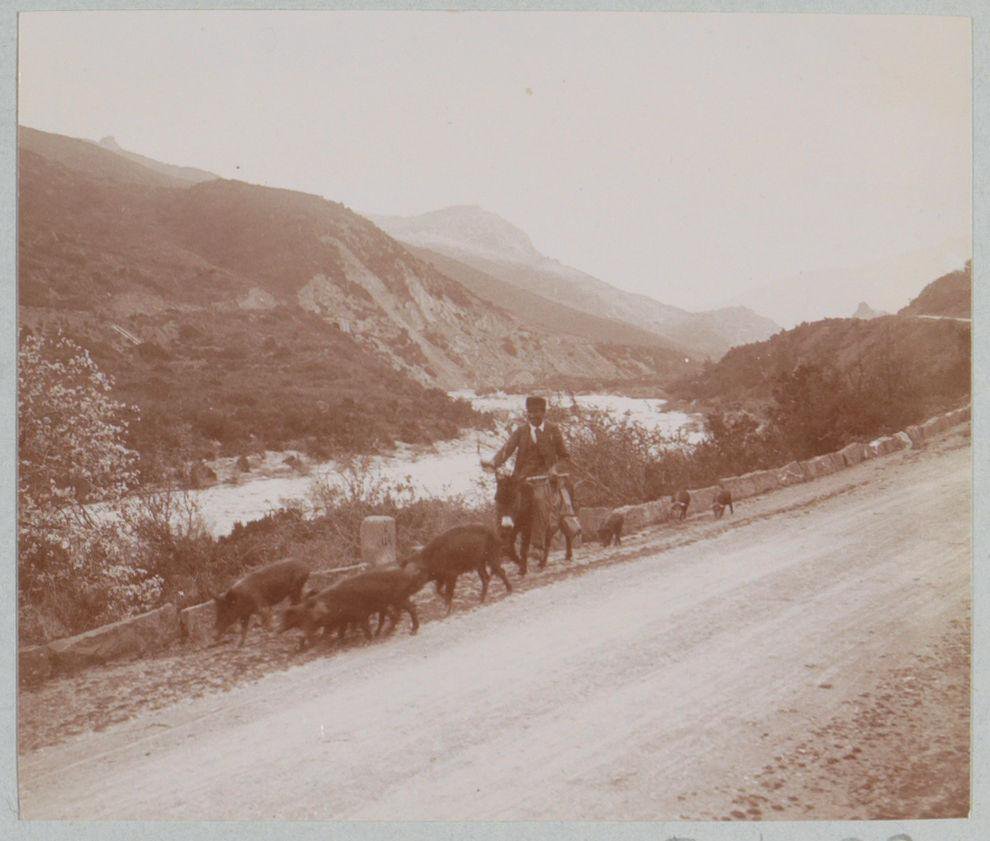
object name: photograph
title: Varkenshoeder met varkens langs een weg op Corsica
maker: Anonymous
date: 1905-1910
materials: paper, photographic support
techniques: gelatin silver print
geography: corsica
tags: pig, road, path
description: Onderdeel van Fotoalbum van een Franse amateurfotograaf met bezienswaardigheden in Frankrijk, Zwitserland en Italië.